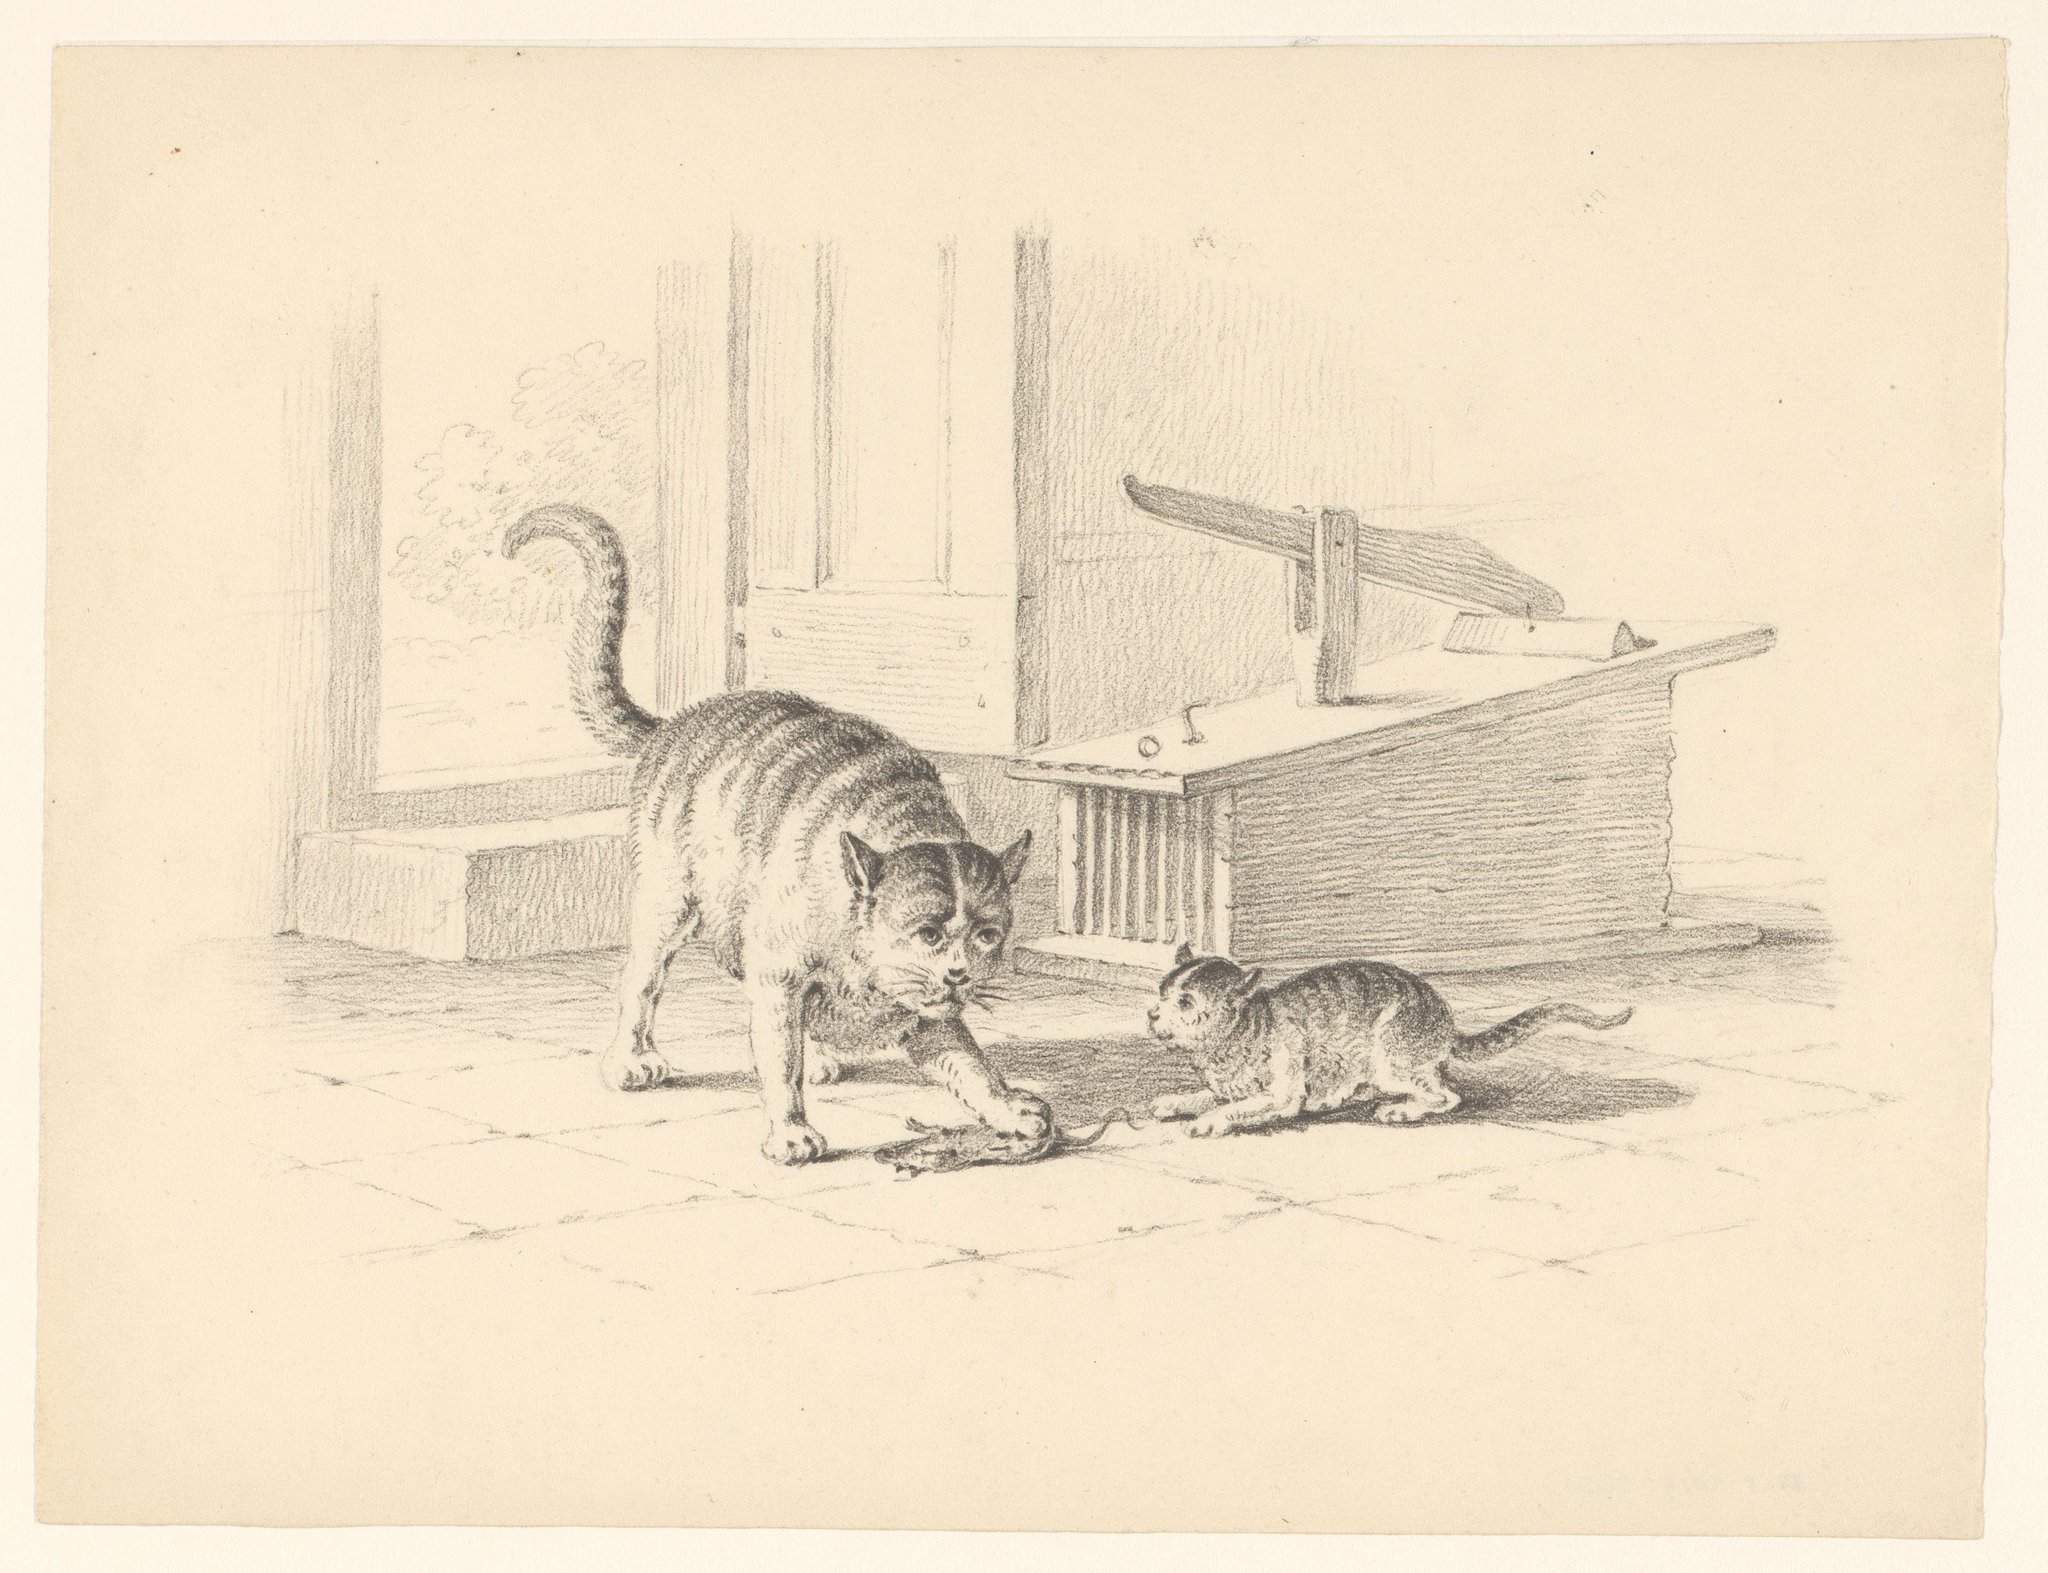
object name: print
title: Twee katten met een muis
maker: Anonymous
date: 1800-1899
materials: paper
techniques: lithograph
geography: netherlands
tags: cat and mouse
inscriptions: collector's mark: Lugt 2228